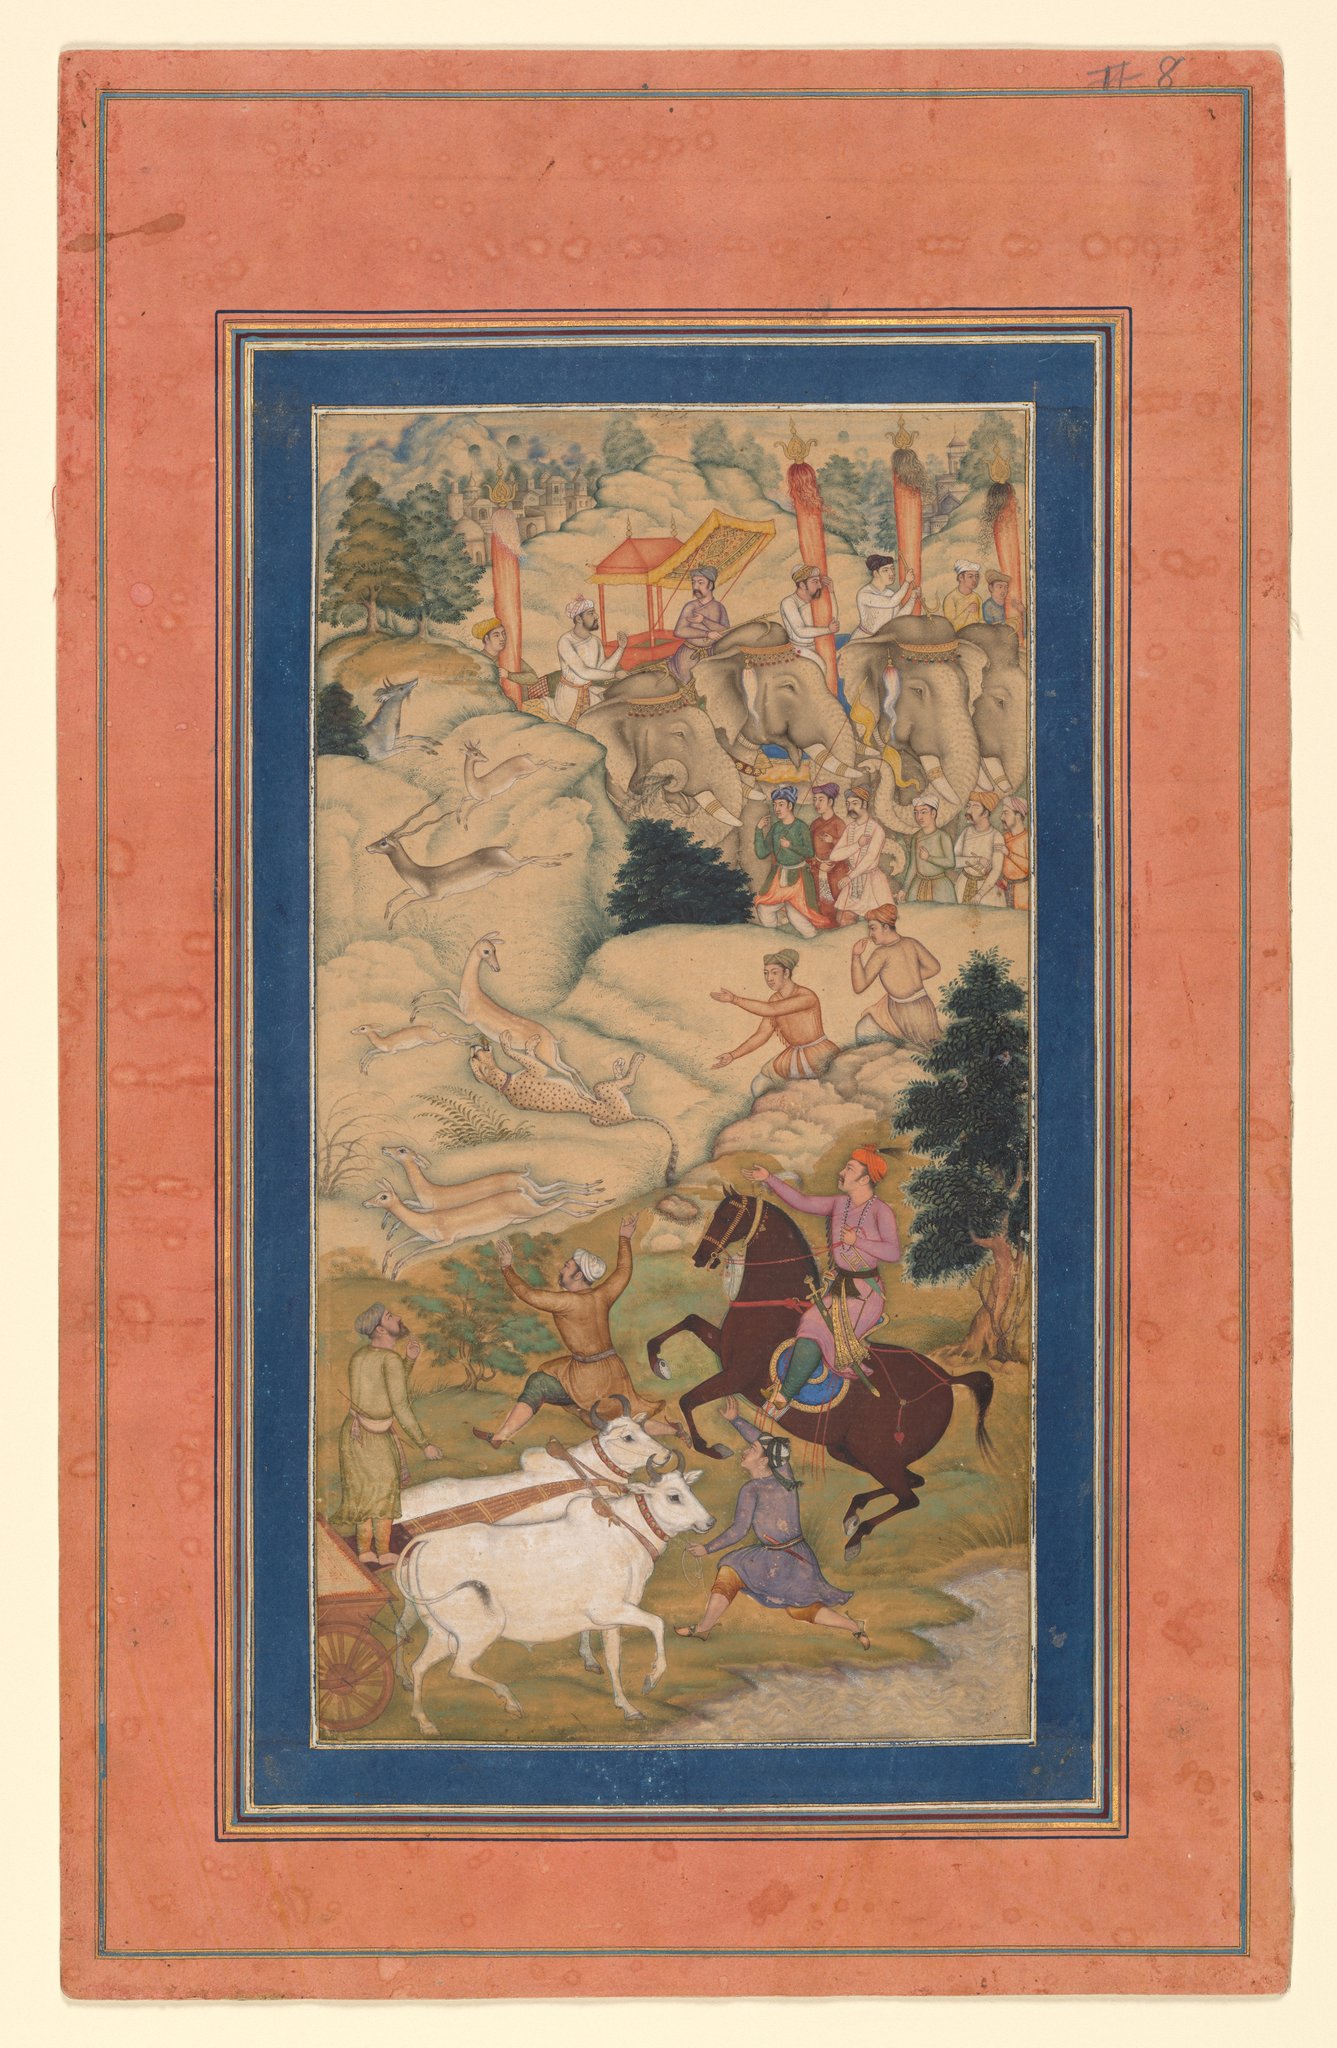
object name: illustrated album leaf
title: "Akbar Hunting with Cheetahs", Folio from a Manuscript of the Akbarnama. Folio from the Davis Album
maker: abu'l fazl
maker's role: author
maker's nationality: indian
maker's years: 1556-1602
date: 1604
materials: gold, ink, paper, watercolor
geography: india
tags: men,cheetahs,cows,deer,elephants,horses